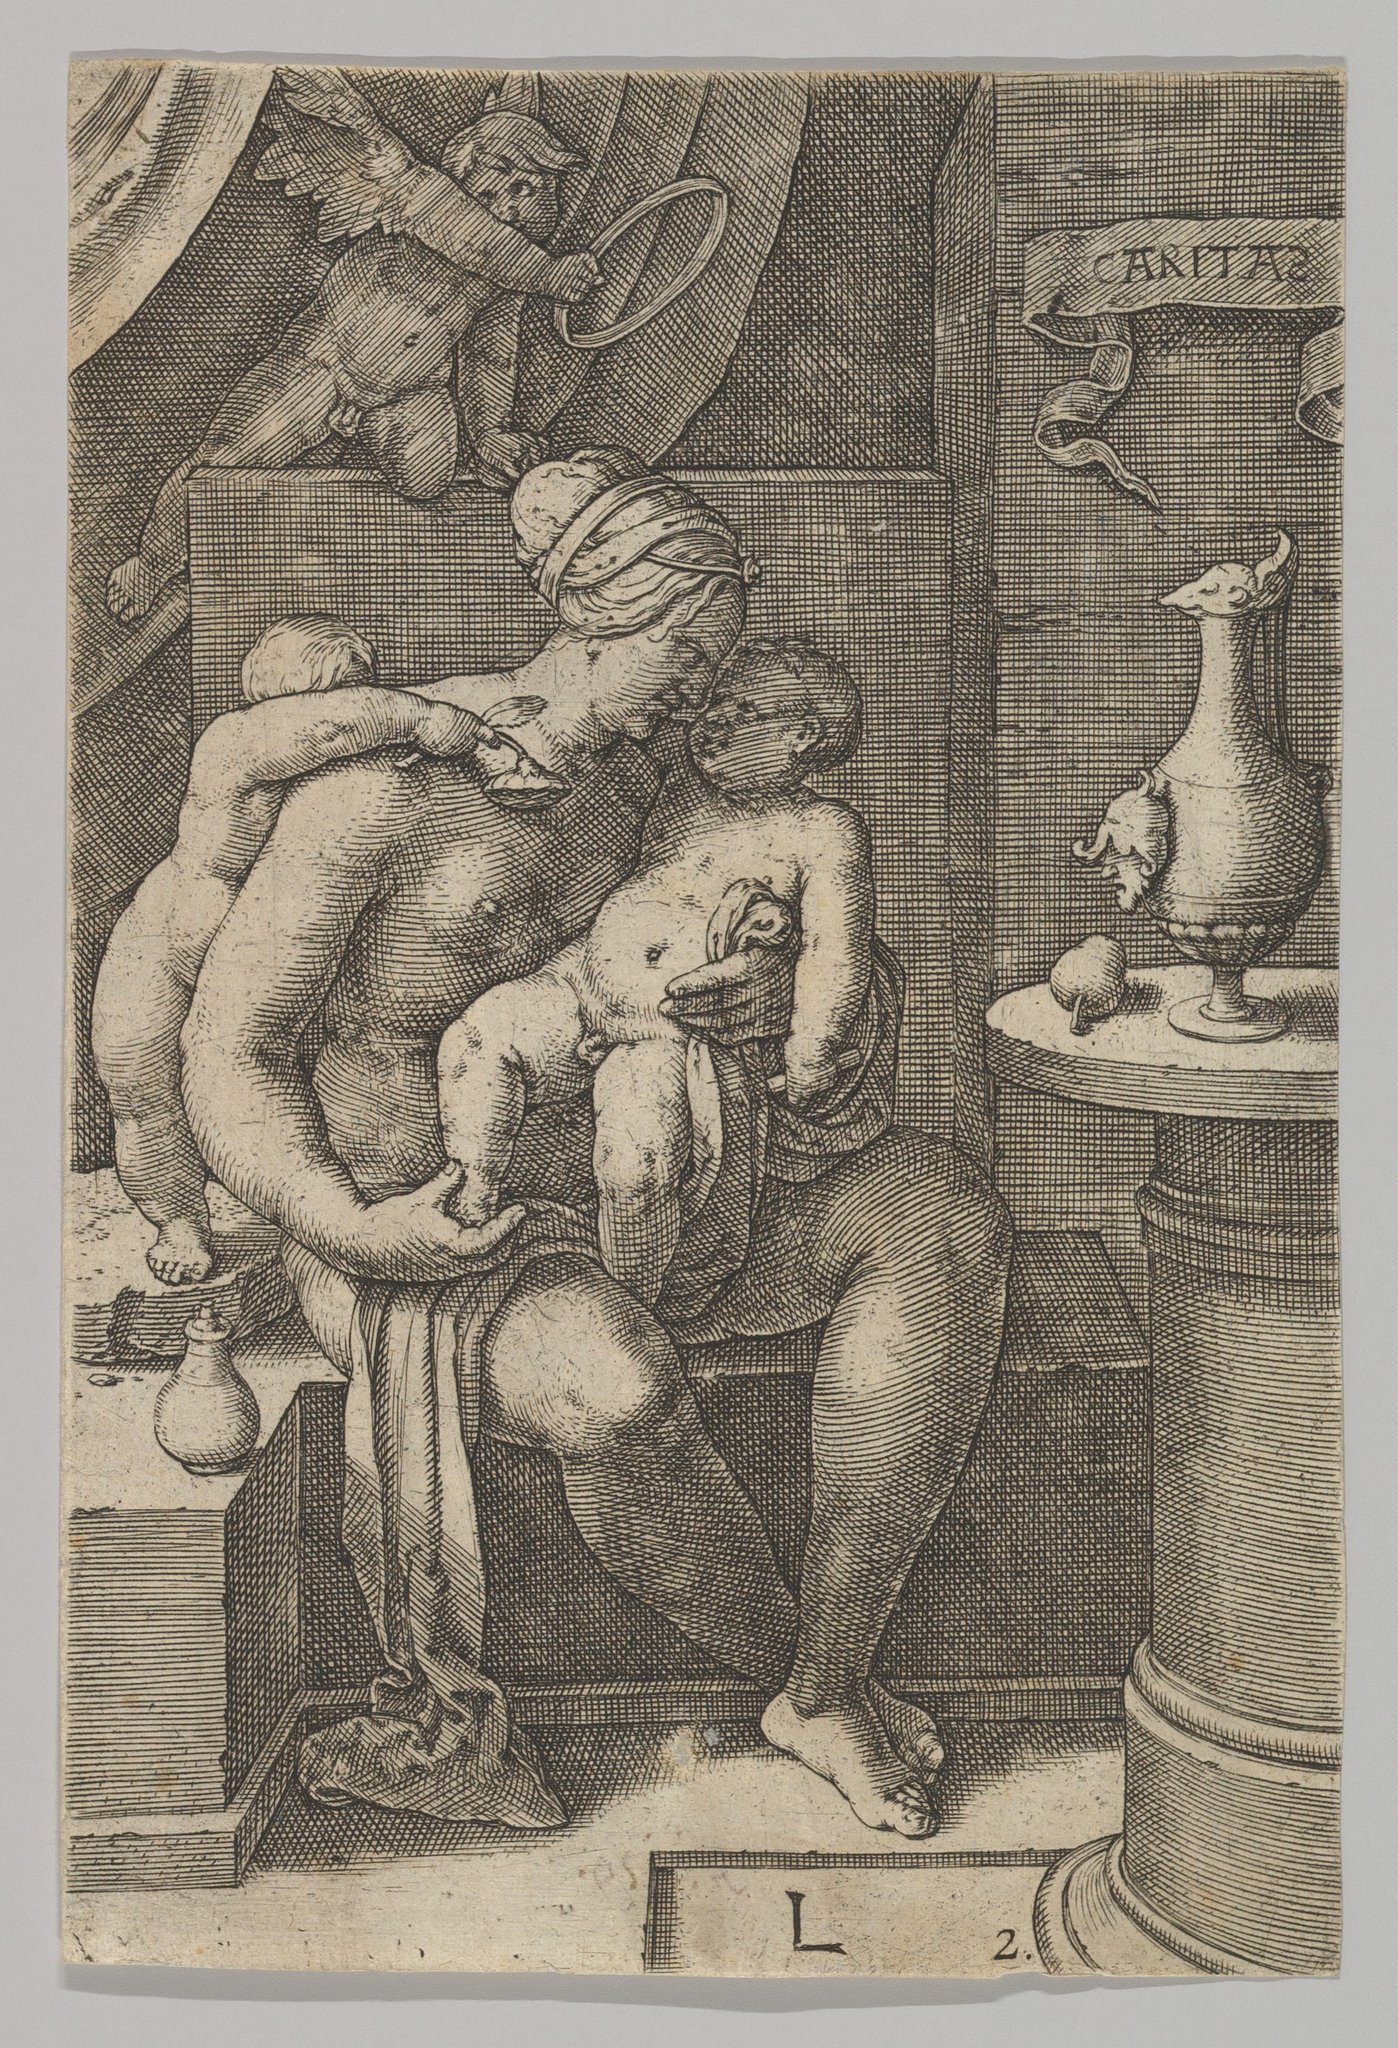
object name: print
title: Charity, from the series The Virtues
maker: lucas van leyden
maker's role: artist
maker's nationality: netherlandish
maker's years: 1494-1533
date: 1530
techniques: engraving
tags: infants,female nudes,putti